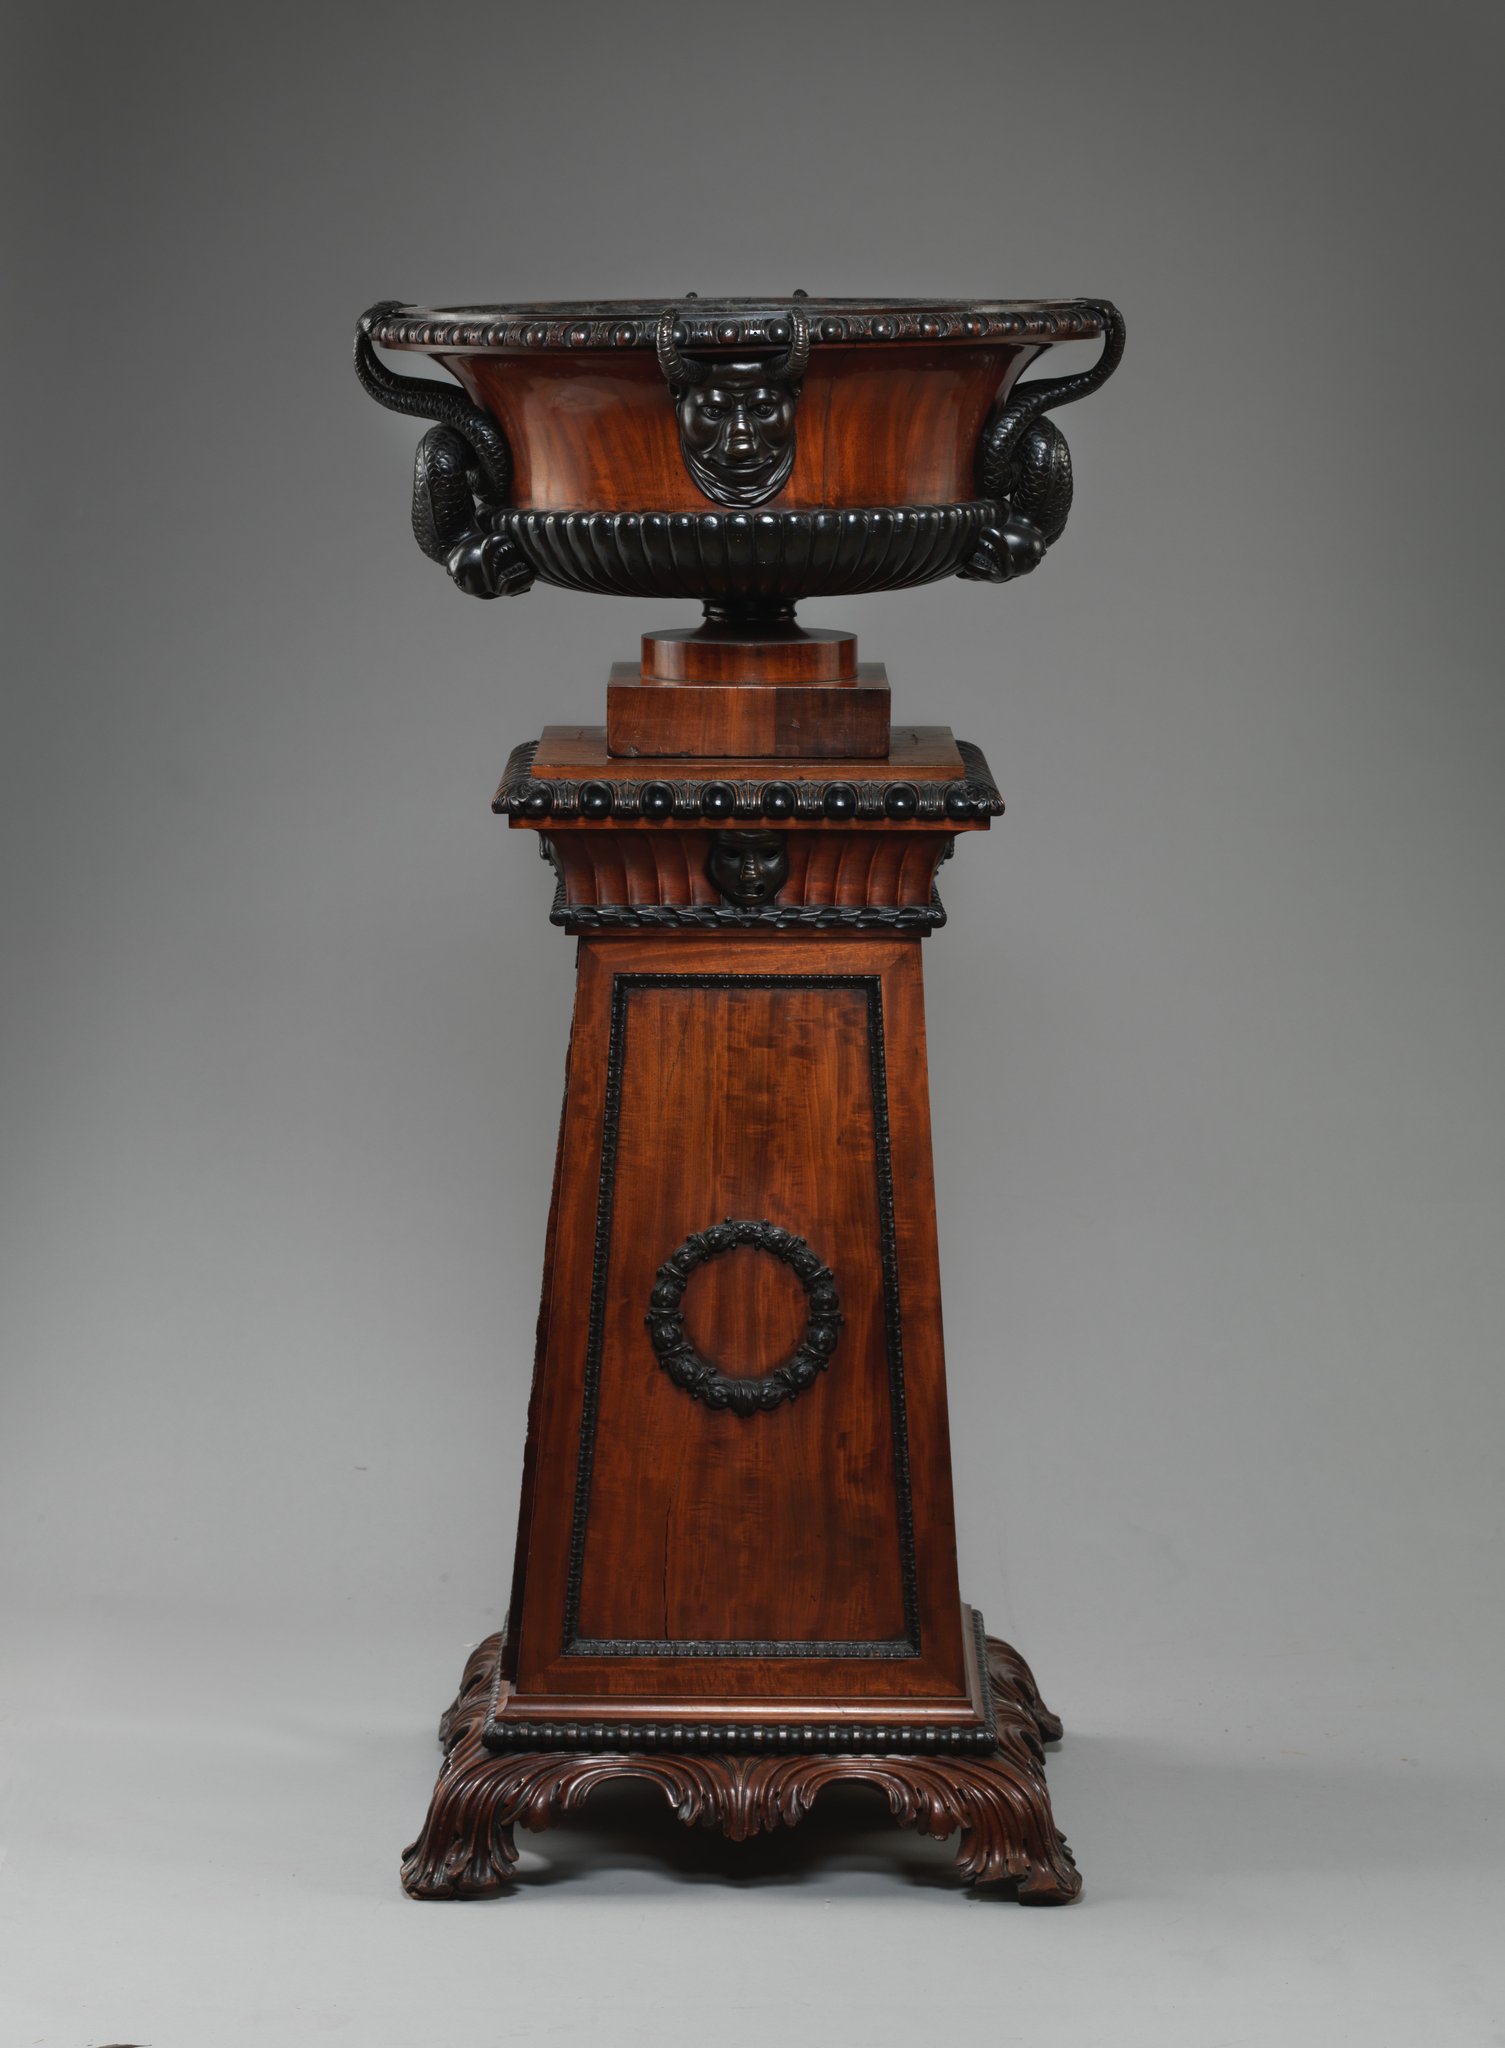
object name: wine cistern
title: Wine cistern (urn and pedestal) (one of a pair)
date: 1820-1830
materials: bronze, wood